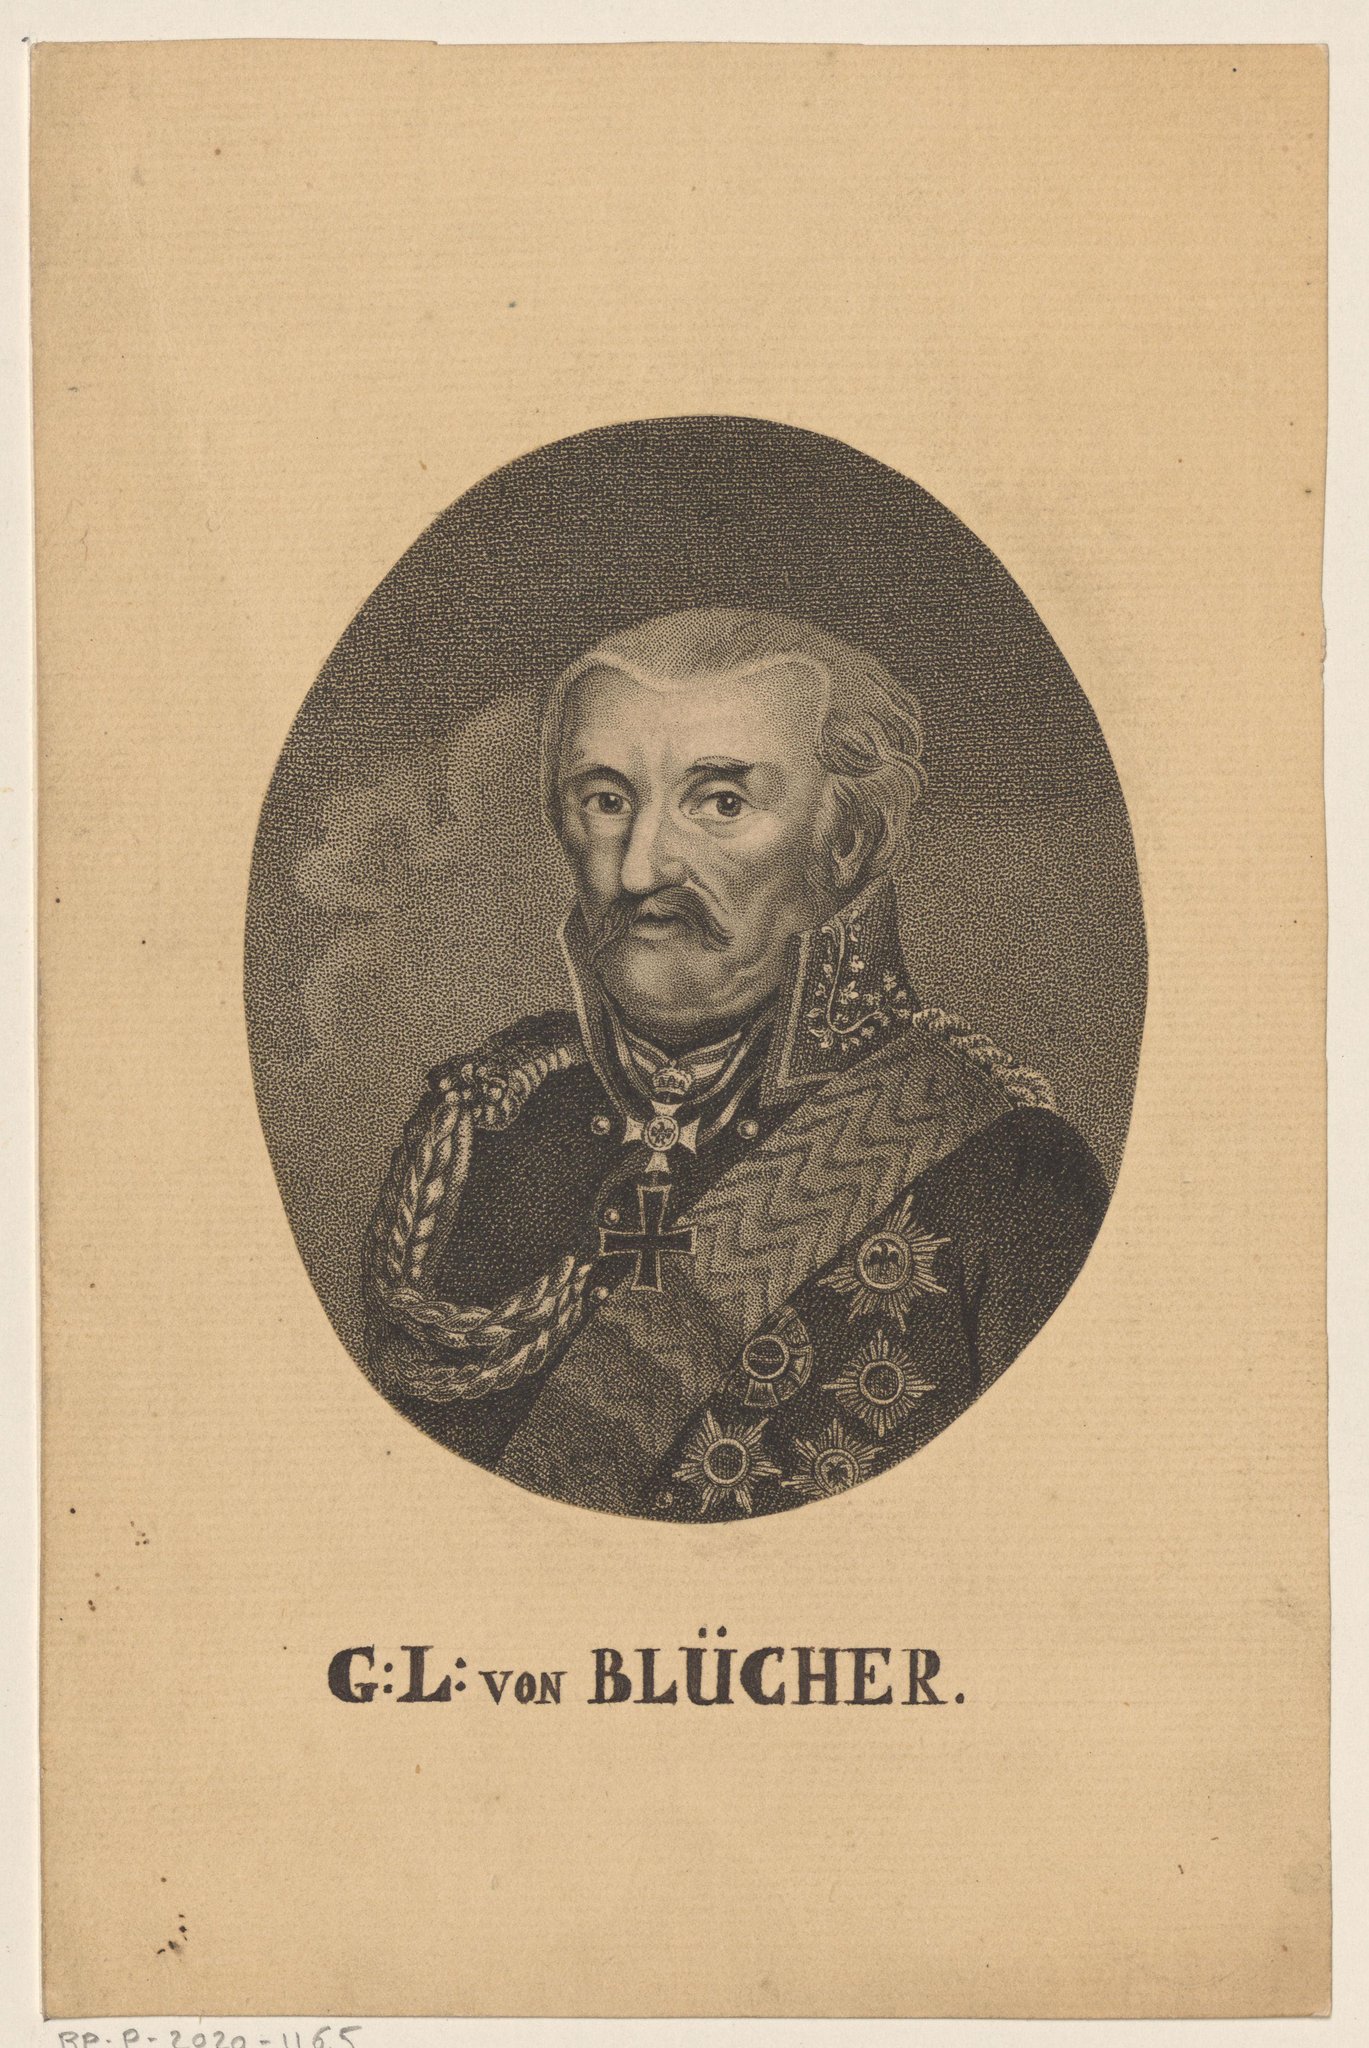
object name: print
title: Portret van Gebhard Leberecht von Blücher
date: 1800-1821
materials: paper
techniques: etching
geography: zutphen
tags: commander-in-chief, general, marshal, historical persons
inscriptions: inscription: ‘G:L: von Blücher.’